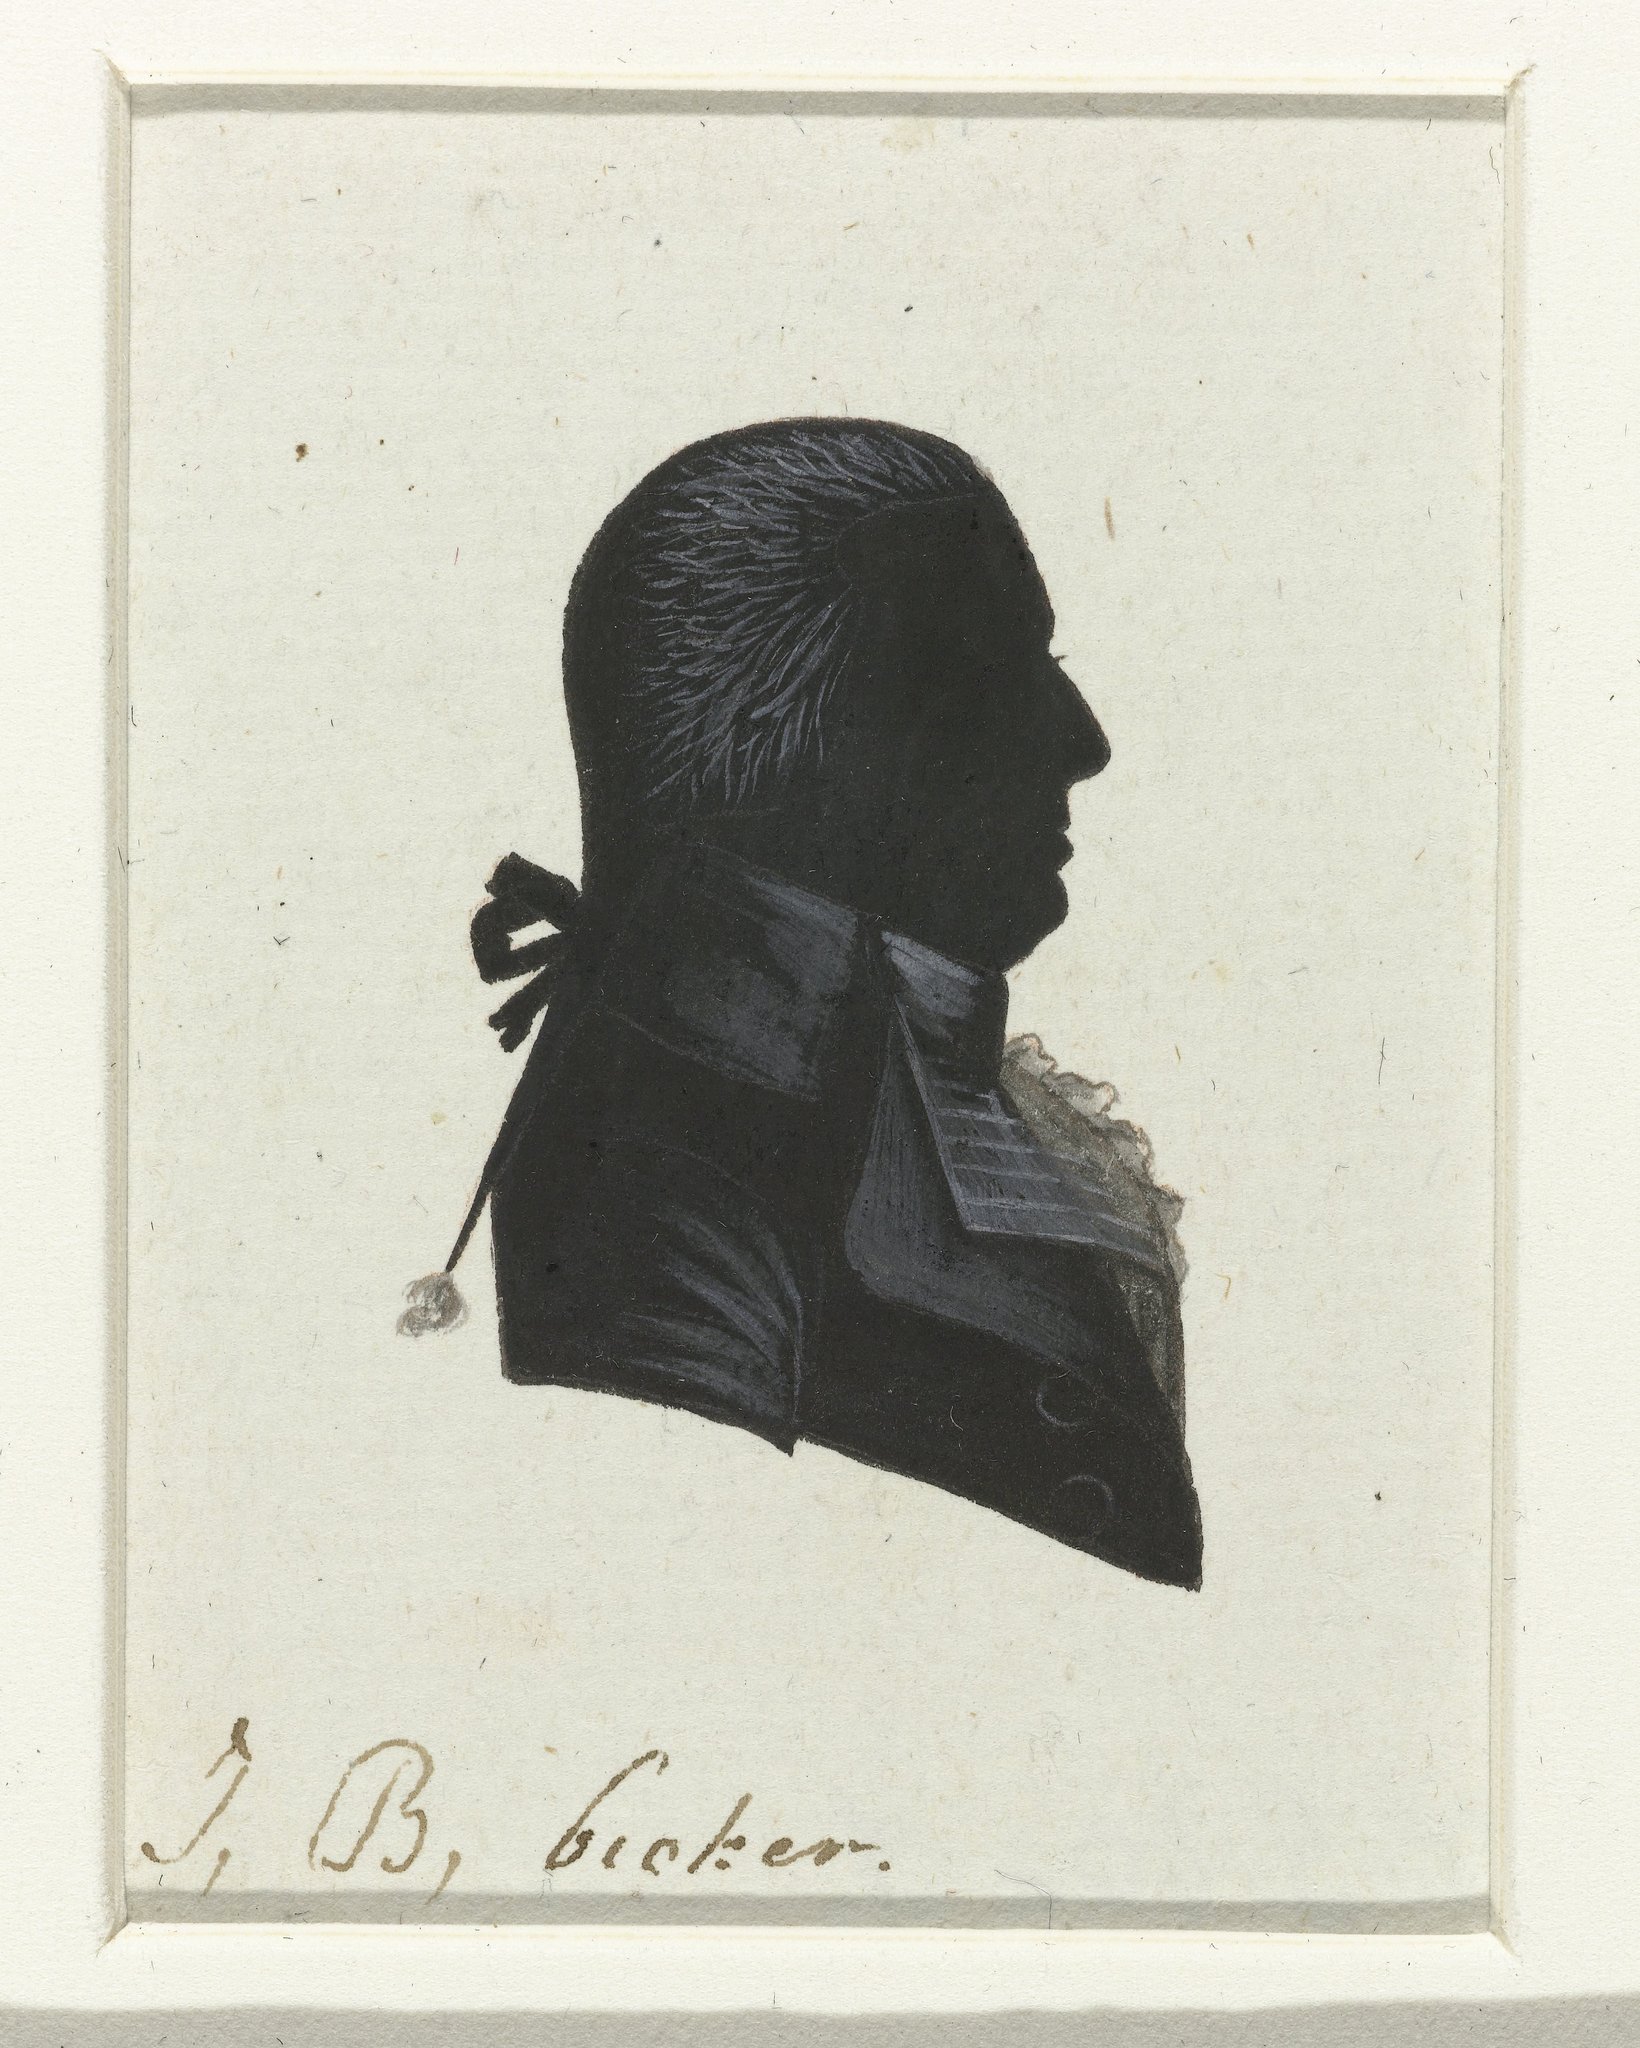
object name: silhouette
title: Representanten van de eerste Nationale Vergadering van de Bataafse Republiek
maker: hausdorff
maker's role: draughtsman, print maker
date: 1796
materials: ink, paper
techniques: drawing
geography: netherlands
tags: amsterdam, the hague, historical persons (+ profile portrait)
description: Silhouettes of members of the National Assembly. India ink on paper, 1796. Early in 1795 Stadholder William V fled to England. In the Republic a new regime was installed. A year later, the country held its first general election. Every Dutch man over the age of twenty and not on poor relief was entitled to vote for a candidate to the National Assembly, the parliament of the Batavian Republic, as the country was known between 1795 and 1806. The 126 representatives who sat in the assembly were drawn from the educated, progressive elite of Dutch society.